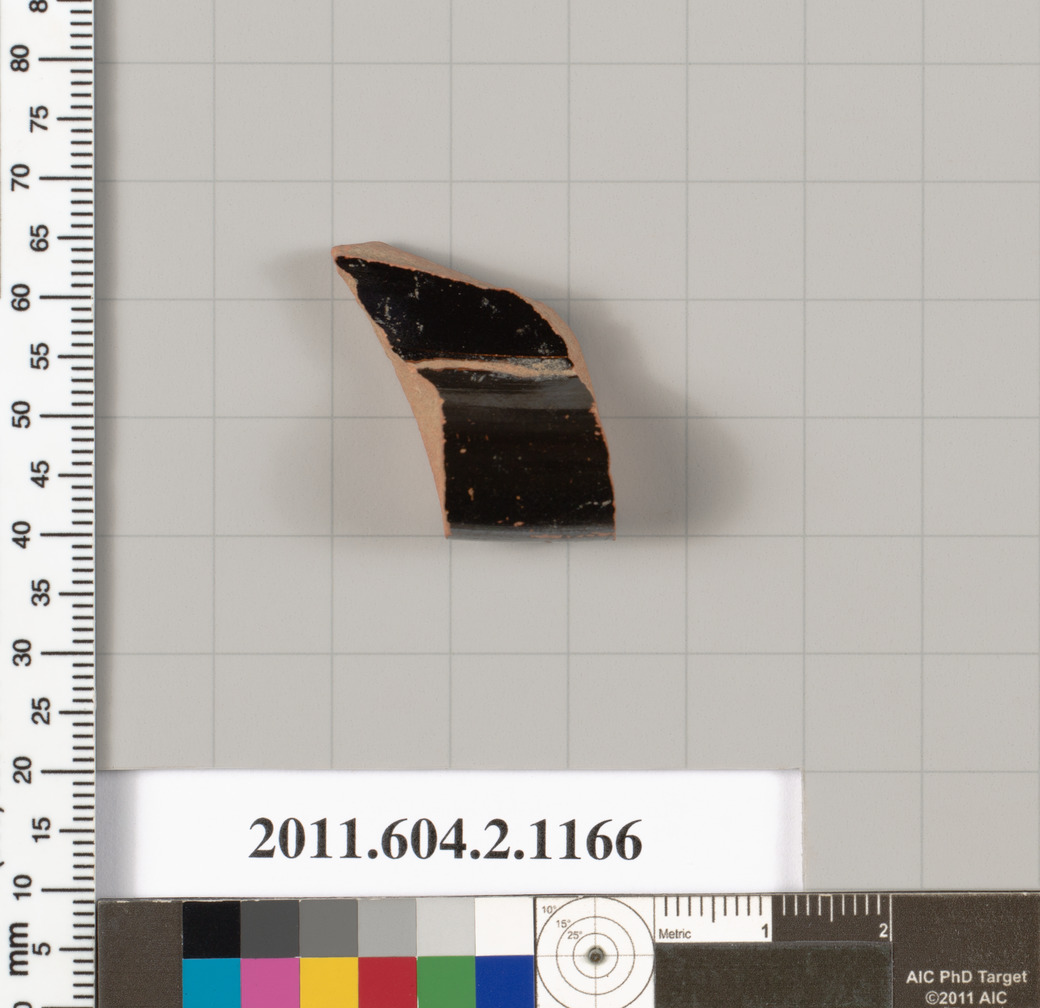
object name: skyphos fragment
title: Terracotta fragment of a skyphos (deep drinking cup)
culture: greek, attic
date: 475-451 BCE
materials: terracotta